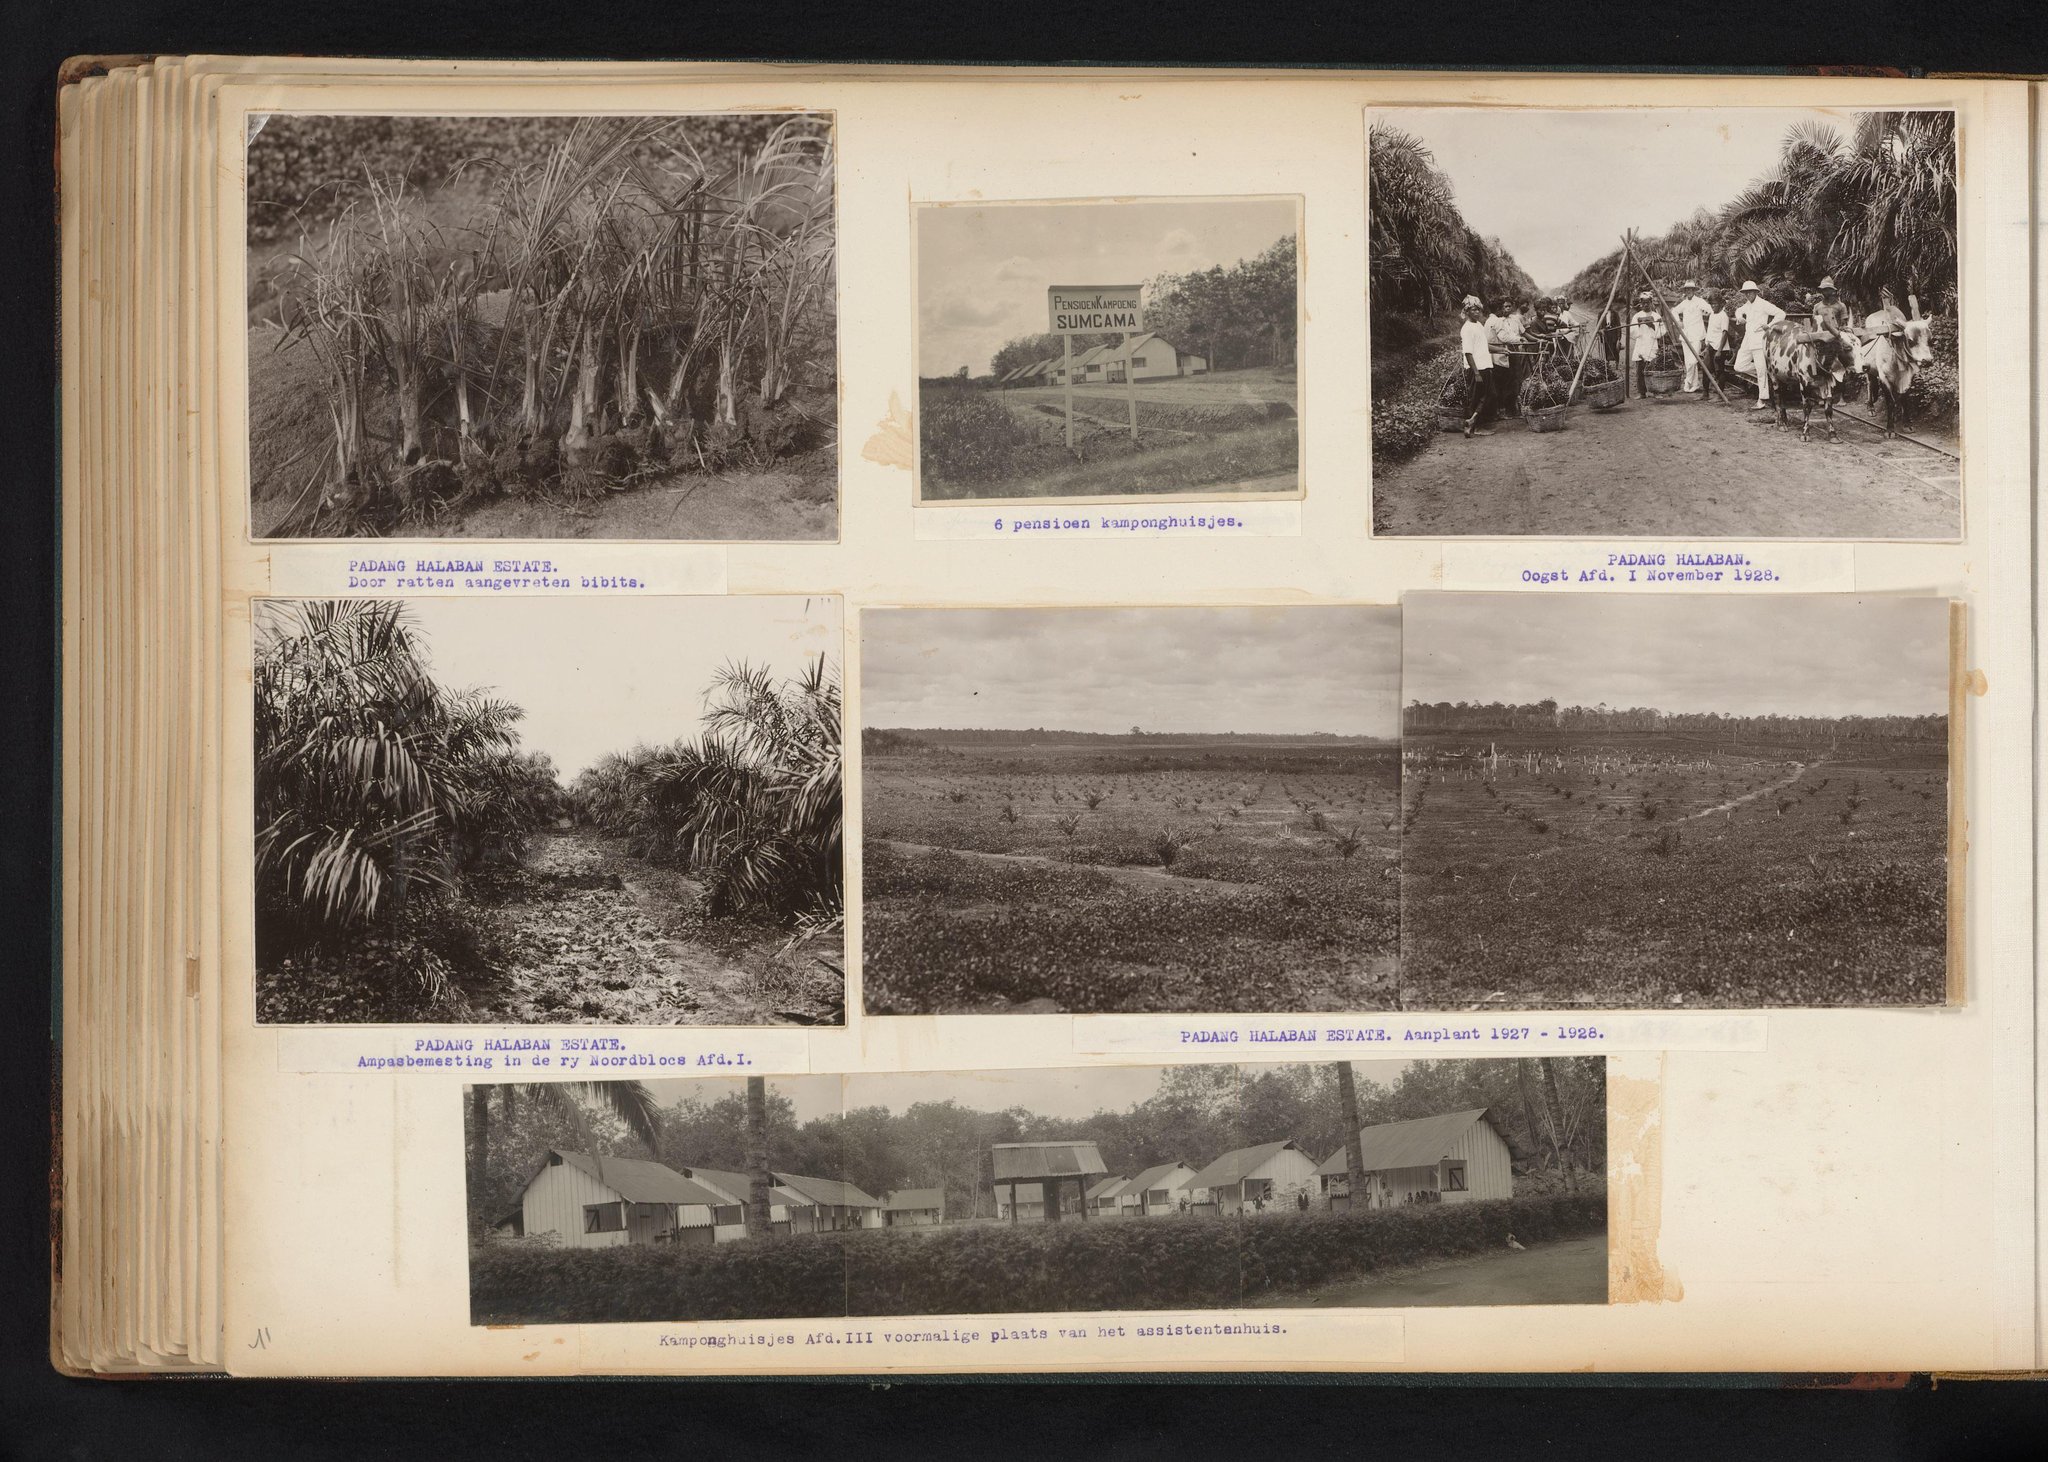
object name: photograph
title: Oliepalmen op Padang Halaban Estate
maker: Anonymous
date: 1927-1928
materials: cardboard, photographic support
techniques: gelatin silver print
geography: sumatra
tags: plantation, (non-fruit) products of plants or trees: palm oil, sumatra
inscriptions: inscription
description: Blad met zes foto's van oliepalmen op Padang Halaban Estate, 1928. Onder de foto's etiketten met onderschriften. Onderdeel van het fotoalbum over de plantages Brussel en Pernantian van de Sumatra Caoutchouc Maatschappij op de Oostkust van Sumatra in de jaren 1910-1935.